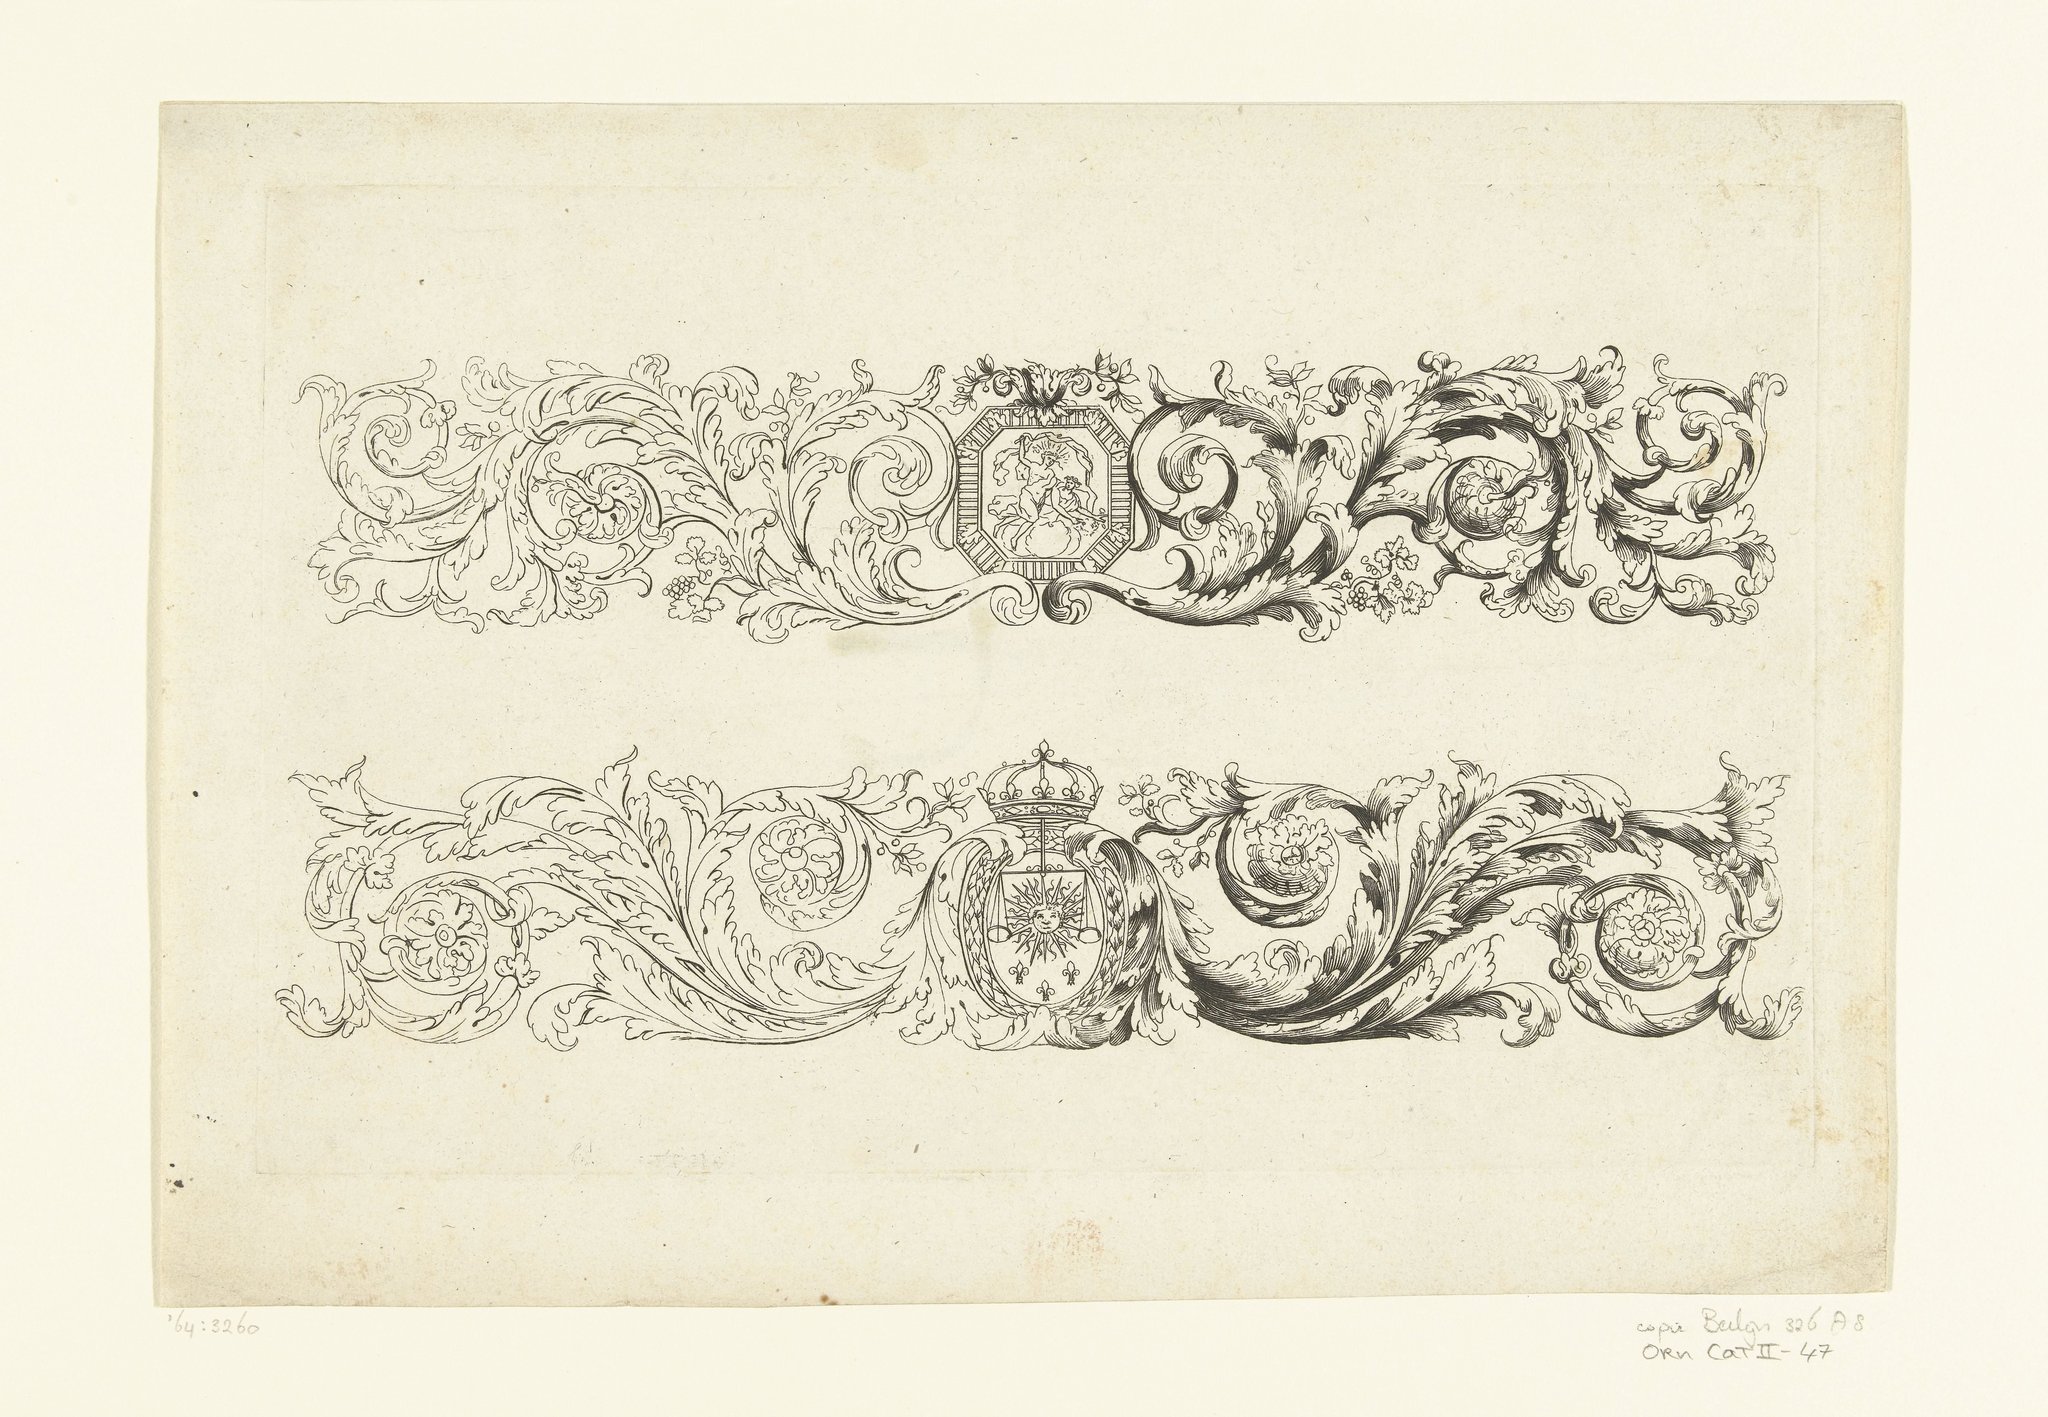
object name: ornament print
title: Friezen met bladranken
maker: Anonymous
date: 1680-1700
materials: paper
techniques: etching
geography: france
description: Bladranken met in het midden respectievelijk een achthoekig paneel met twee goden en een wapenschild met de zon. Op het wapenschild staat de Franse koningskroon.